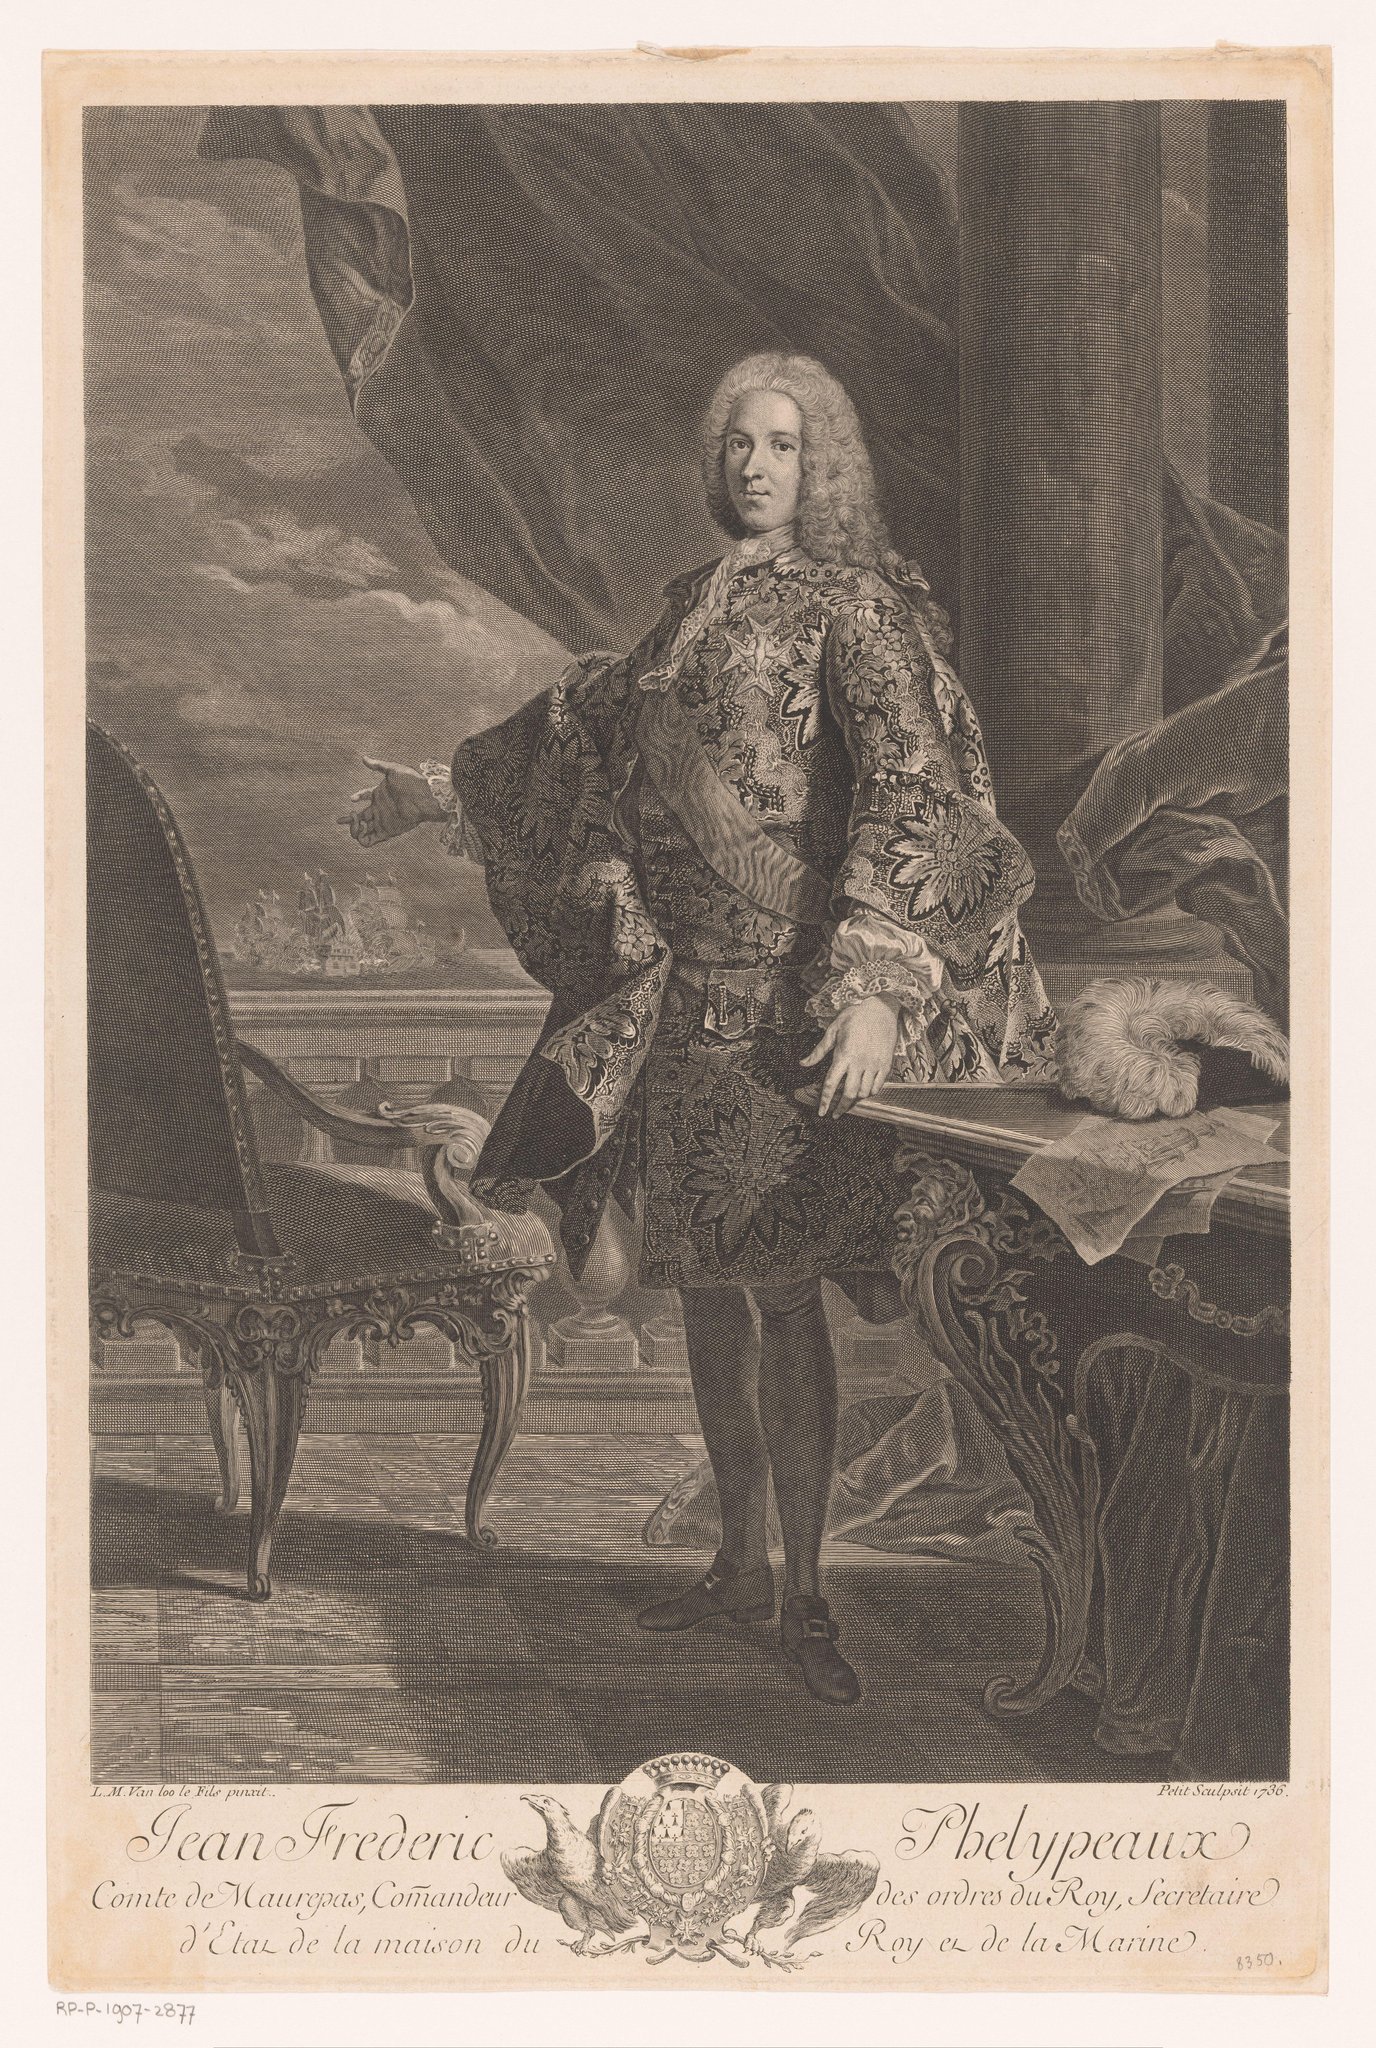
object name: print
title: Portret van Jean-Frédéric Phélypeaux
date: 1736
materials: paper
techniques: engraving, etching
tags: jean-frédéric phélypeaux, official; civil servant; functionary (in general), historical persons, ranks in the navy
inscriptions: collector's mark: Lugt 2228